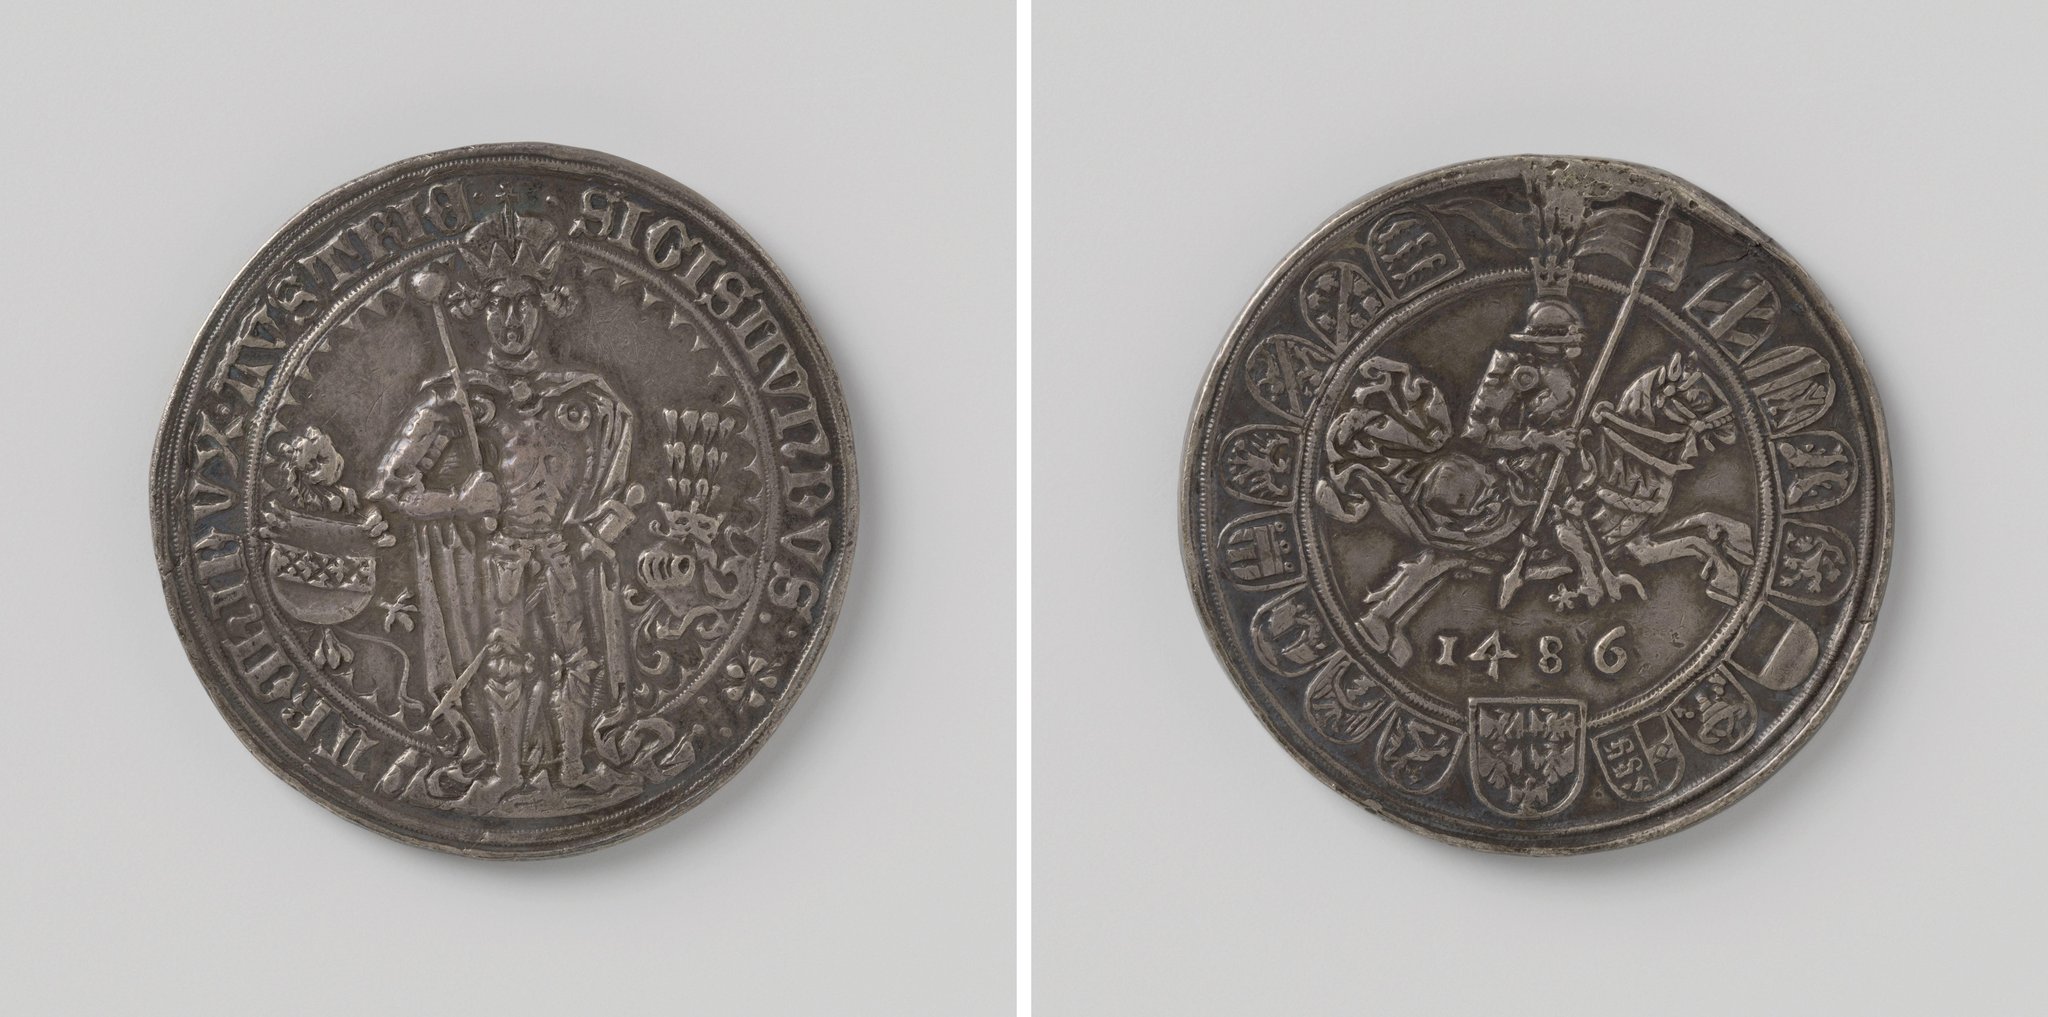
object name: coin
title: Guldiner (taler) van Sigismund, aartshertog van Tirol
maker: wenzel kröndl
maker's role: die cutter, goldsmith, print maker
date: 1486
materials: silver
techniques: striking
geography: hall am inn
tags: aartshertog van tirol sigismund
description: Zilveren munt. Voorzijde: portret man met kroon en scepter tussen leeuw met wapenschild en helm binnen omschrift. Keerzijde: ruiter met vaandel in hand boven jaartal binnen rand van zestien wapenschilden. Tyroler Guldengroschen.